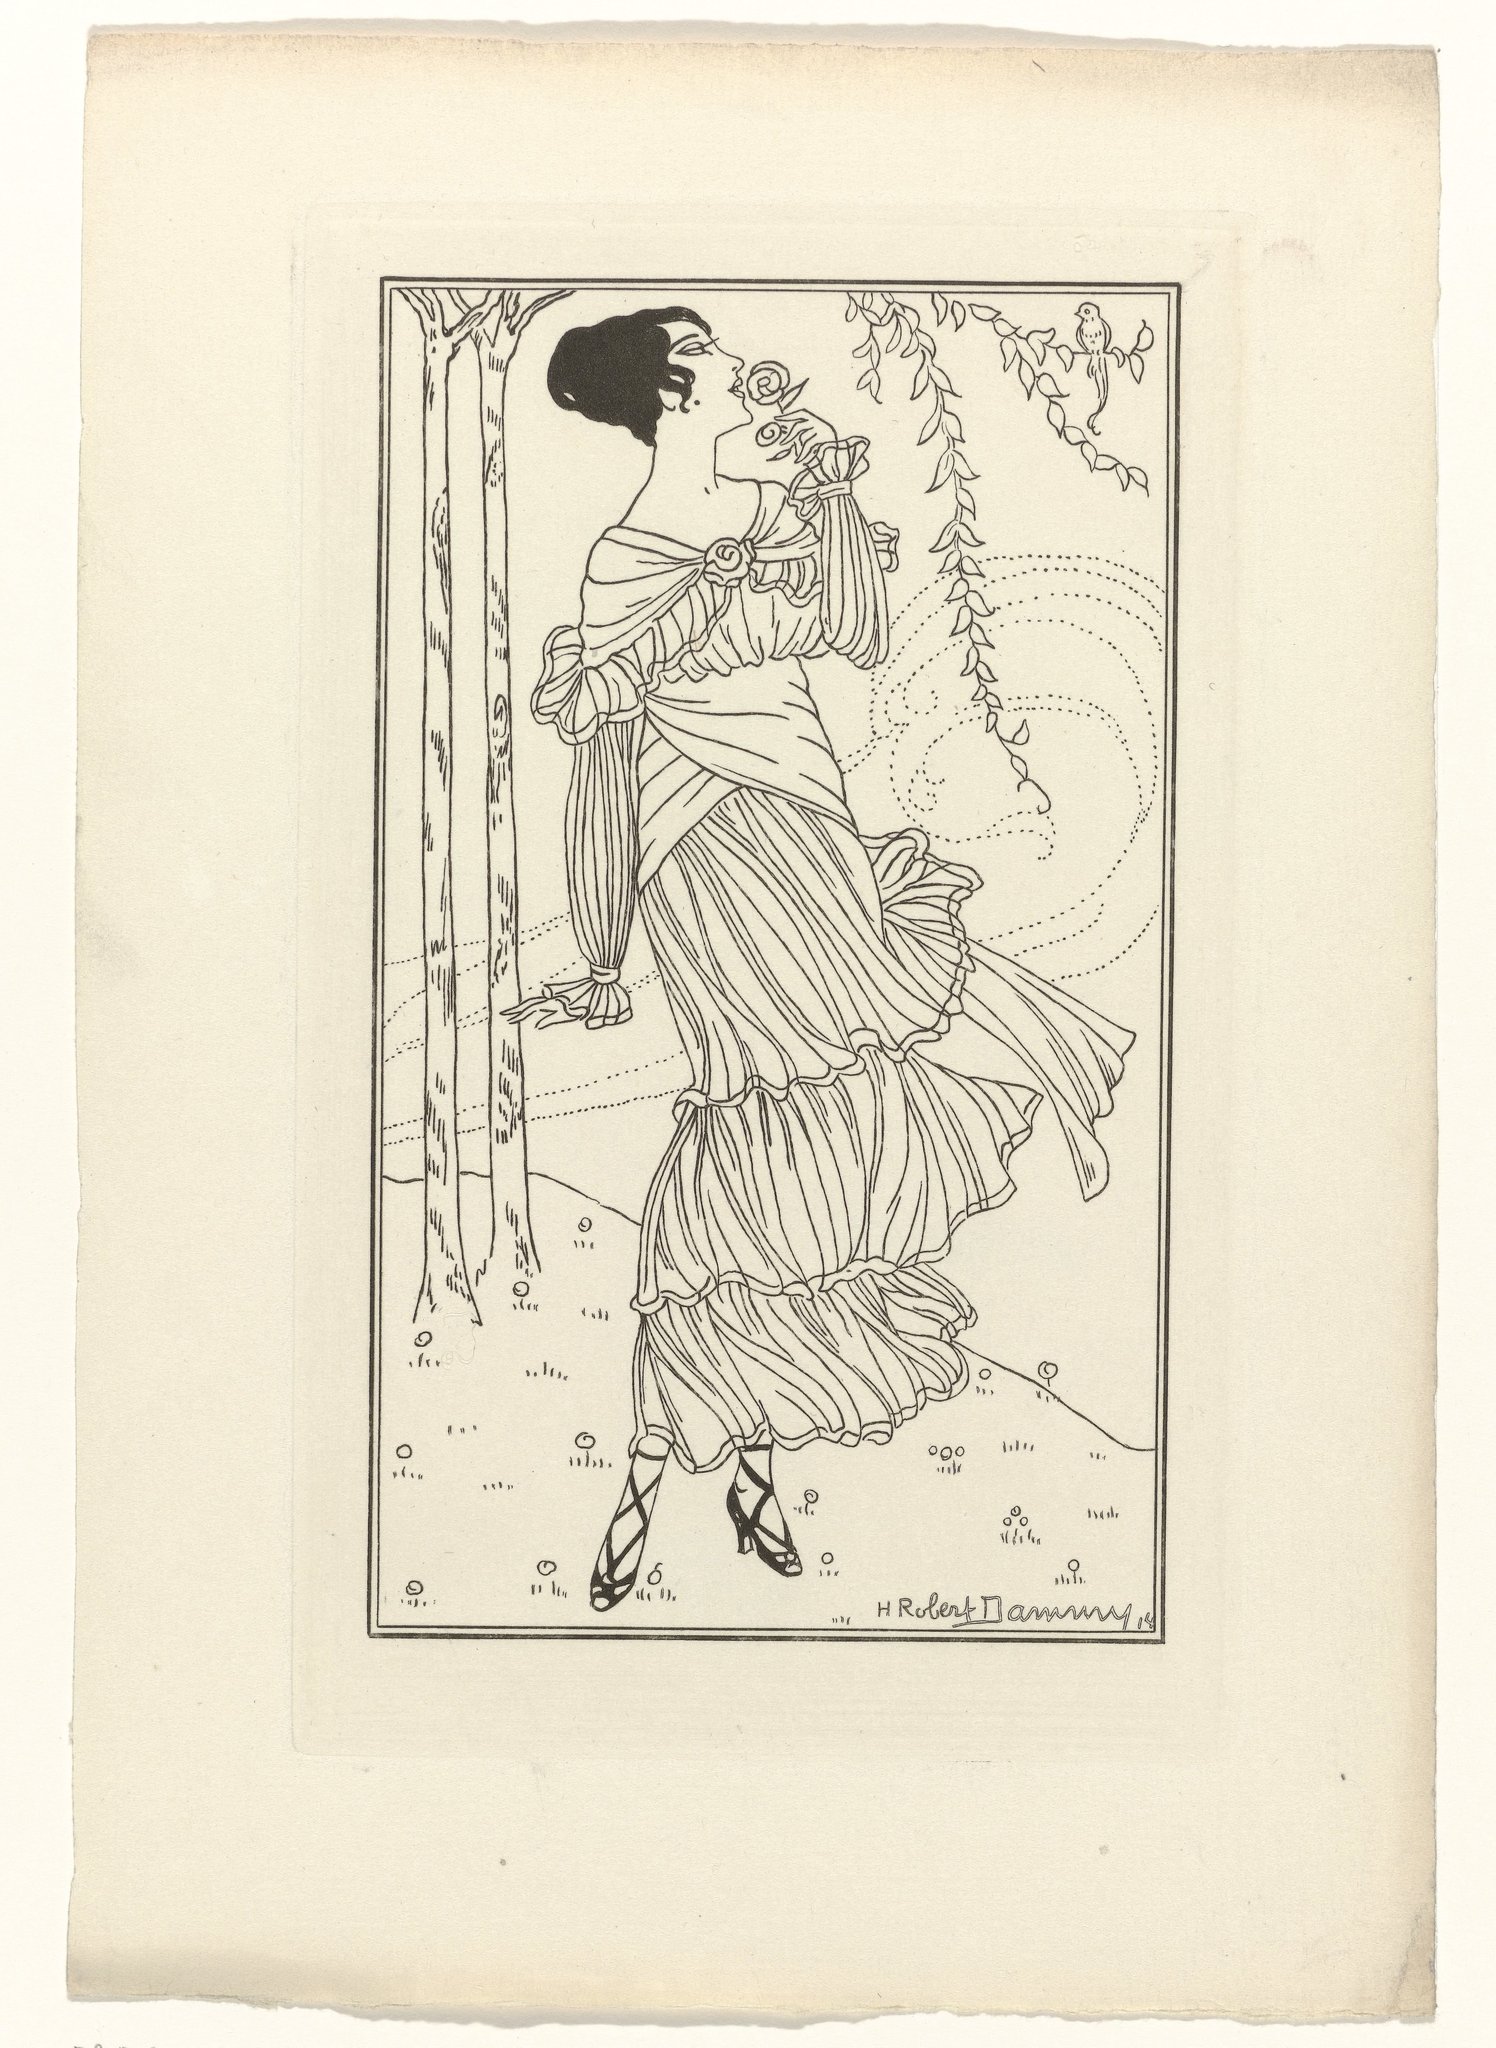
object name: fashion print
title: Journal des Dames et des Modes, Costumes Parisiens, 1914, No. 159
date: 1914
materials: paper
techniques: engraving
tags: flowers, dress, gown (tea-gown) (+ women's clothes), birds, fashion plates, smell, smelling (one of the five senses) - aa - female human figure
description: Japon voor een tuinfeest van witte mousseline en oranje 'liberty'. Pumps met gekruiste banden. Proefdruk van een prent uit het modetijdschrift Journal des Dames et des Modes (1912-1914).